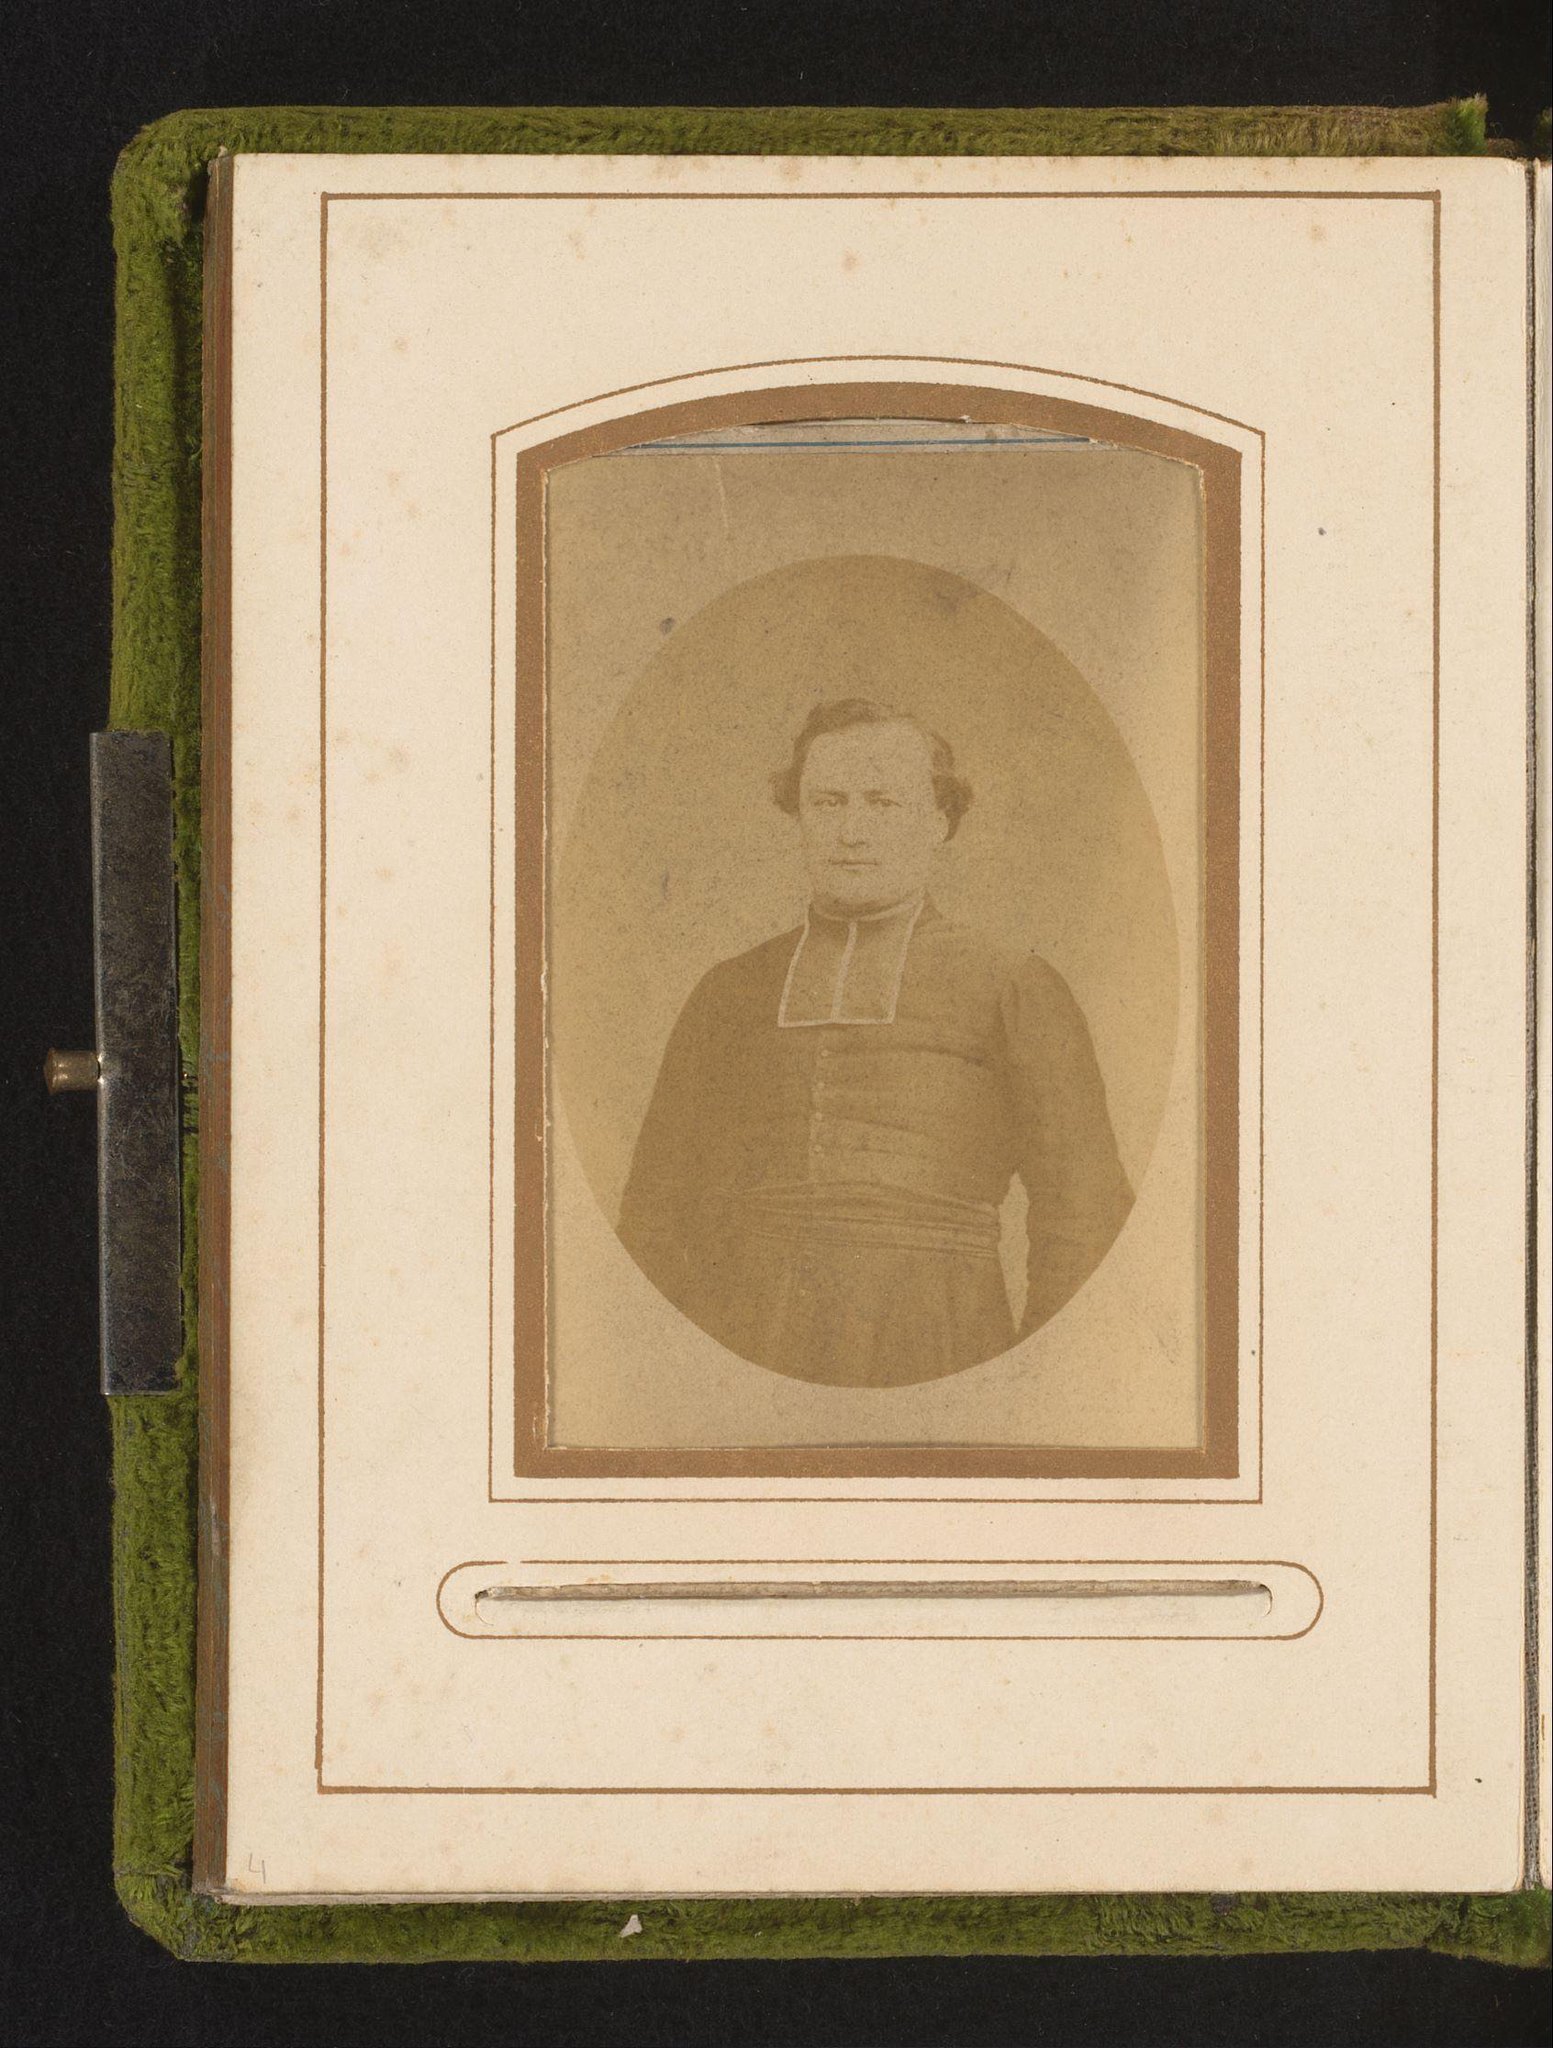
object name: album leaf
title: Portret van een man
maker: Anonymous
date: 1860-1900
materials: cardboard, photographic support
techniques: albumen print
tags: adult man, historical persons, organization, functionaries and dignitaries in churches and in related institutions